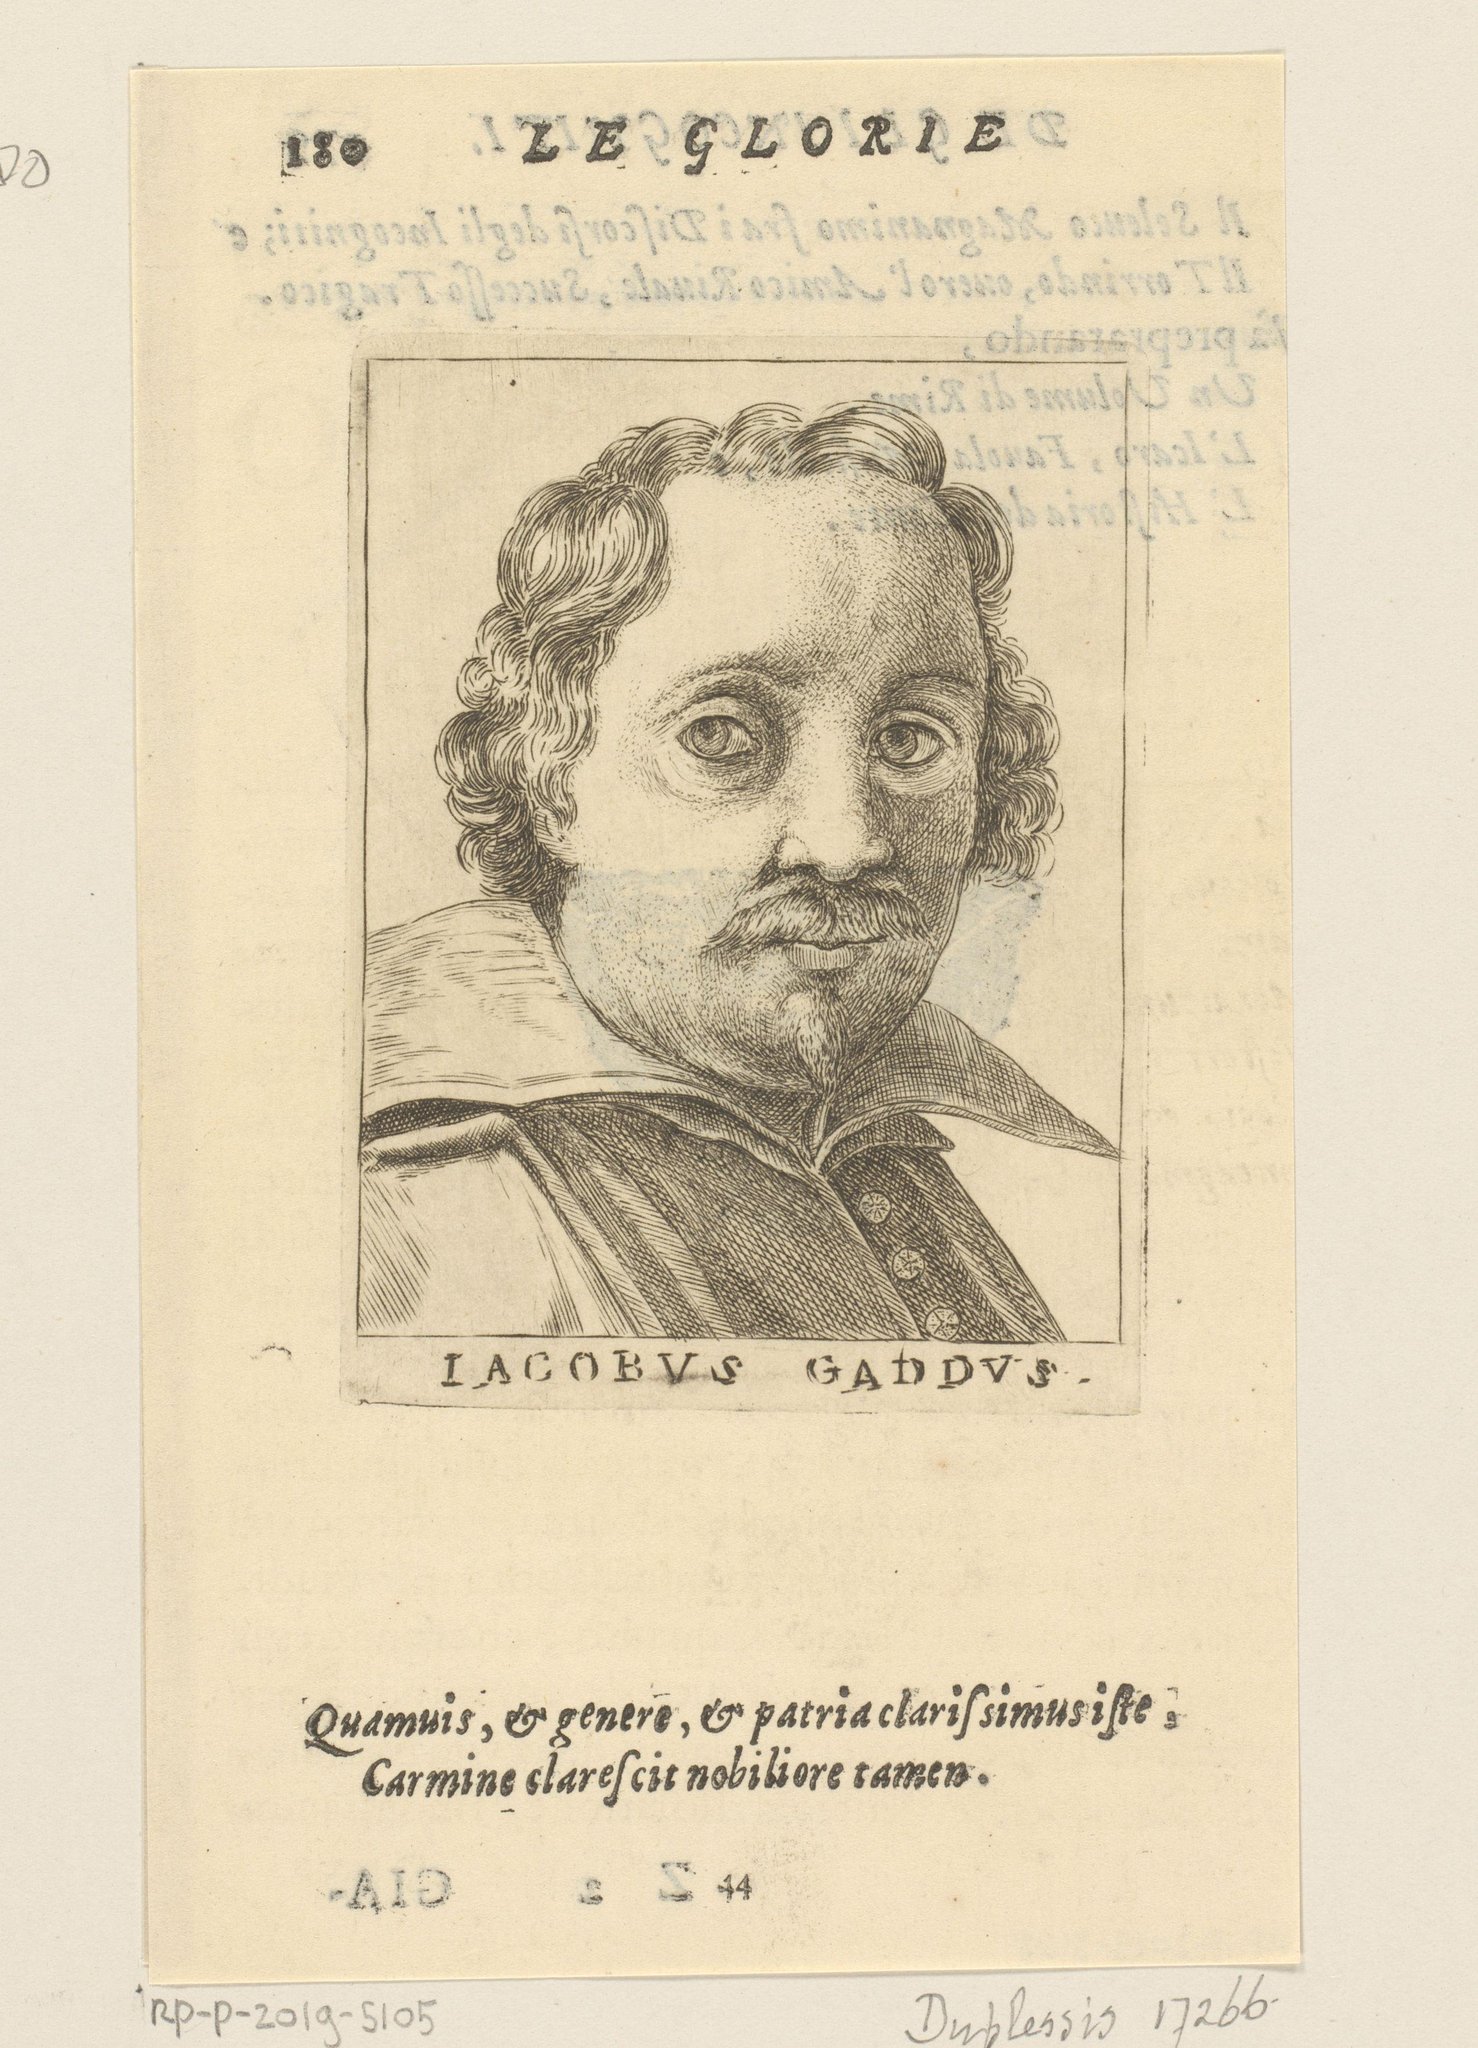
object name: print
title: Iacobus Gaddus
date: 1647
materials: paper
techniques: engraving, etching, letterpress printing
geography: venice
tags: scholar, philosopher, historical persons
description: Prent uit: Le glorie degli Incogniti o vero gli huomini illustri dell'accademia de signori Incogniti di Venetia. Venetië: Francesco Valvasense, 1647, p. 180.